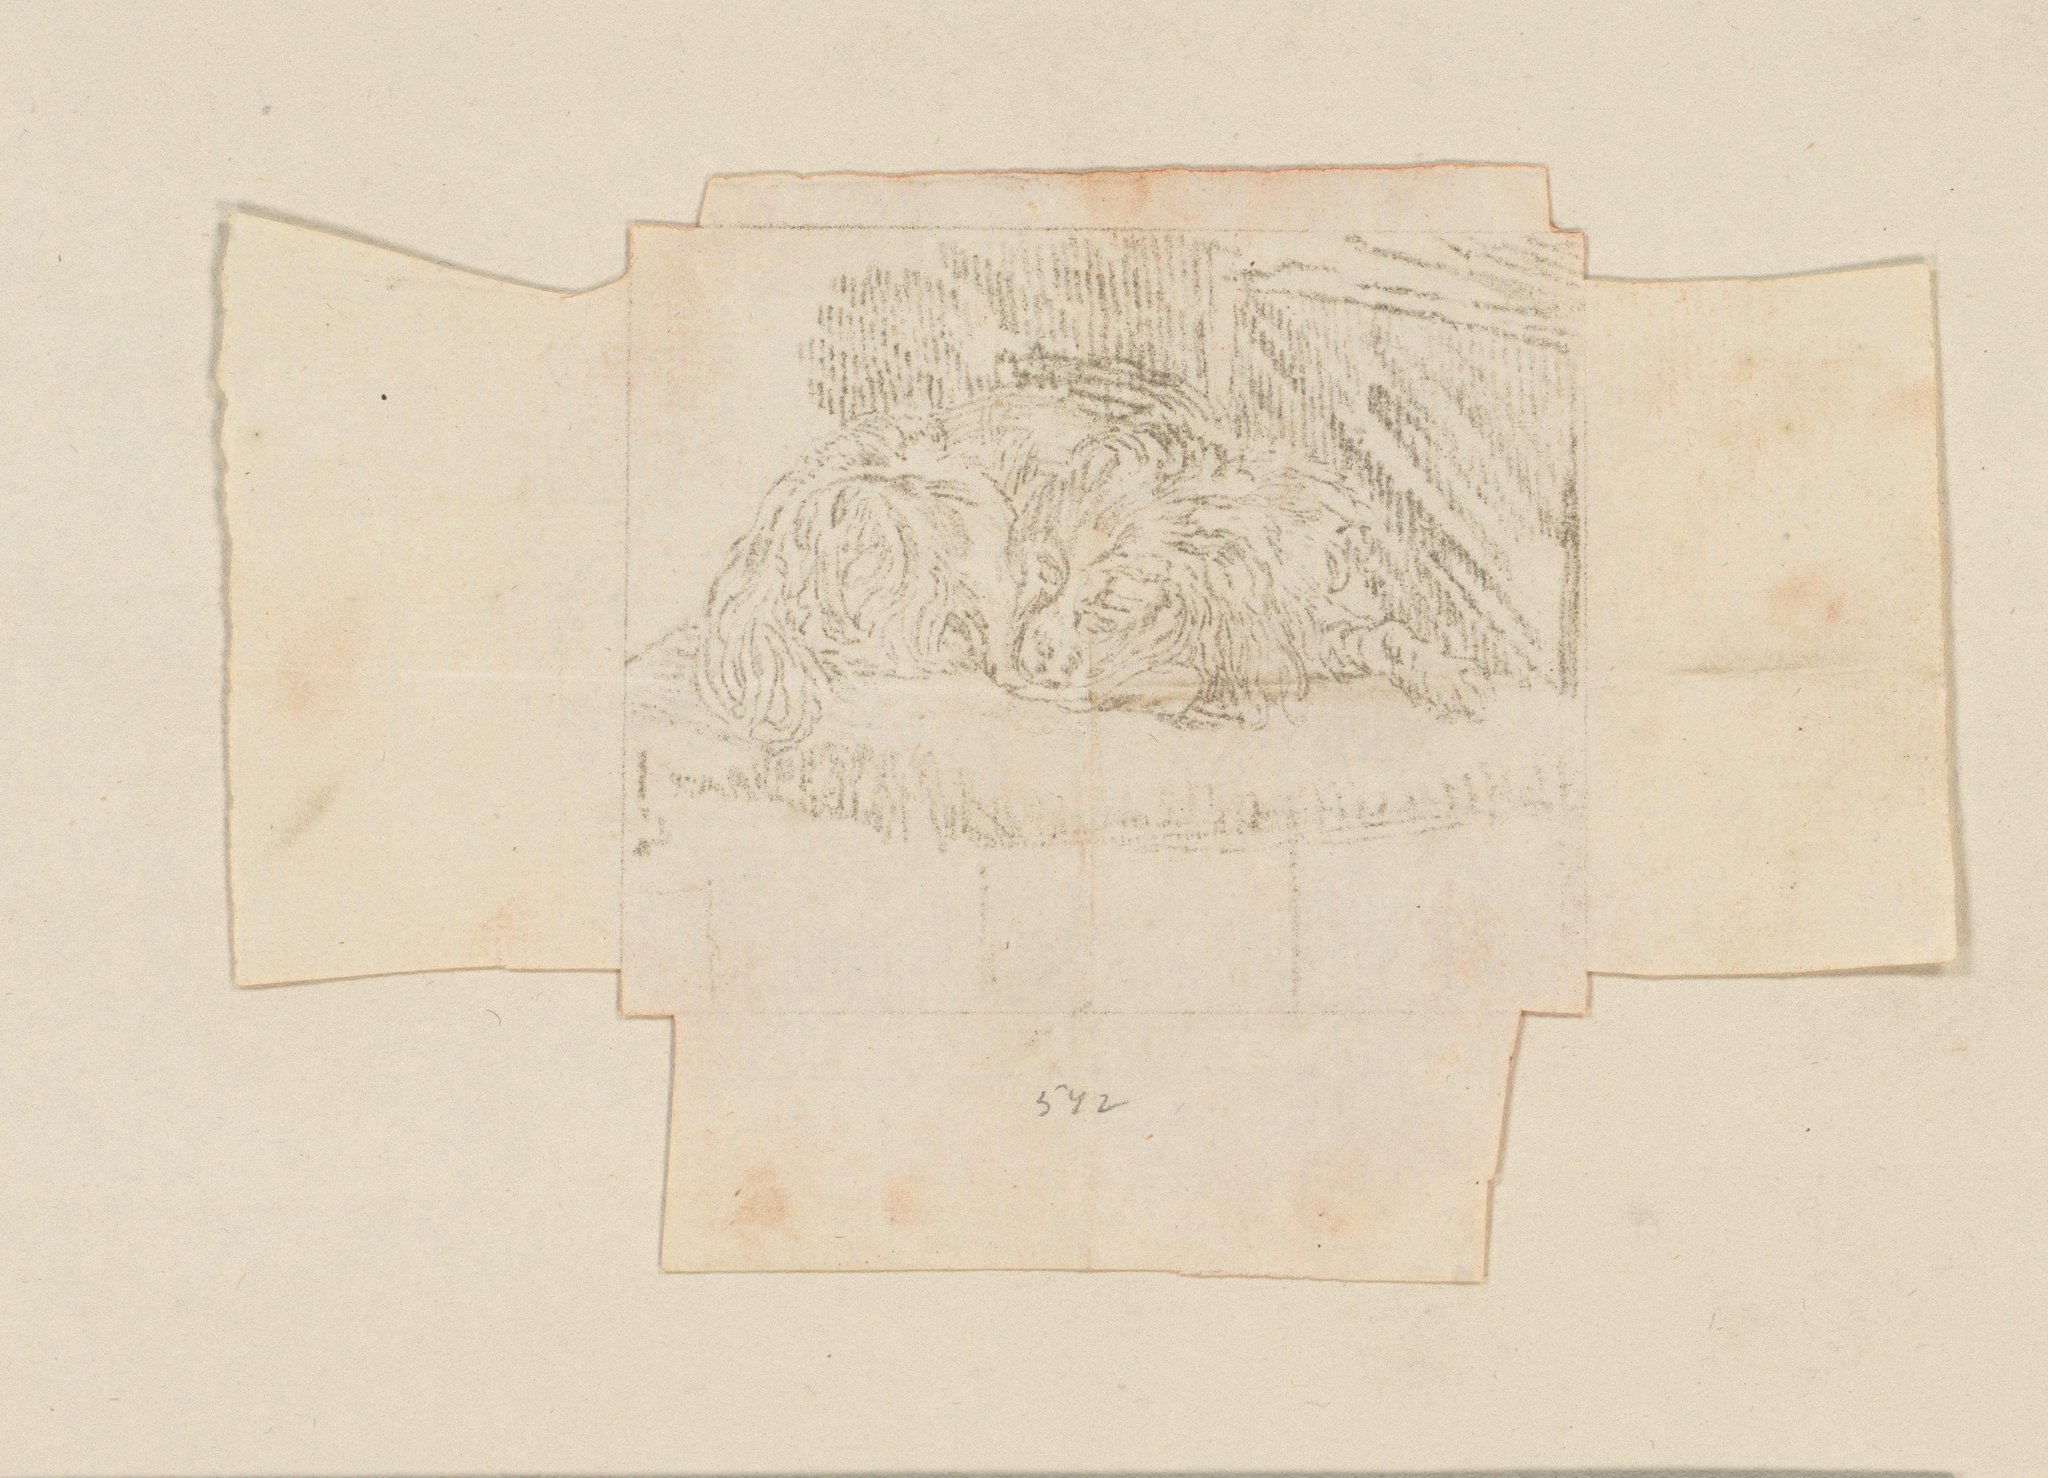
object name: drawing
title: Liggende hond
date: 1777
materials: chalk, paper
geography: amsterdam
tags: dog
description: Over de doordruktekeningen van Ploos van Amstel zie LNP, p. 201.